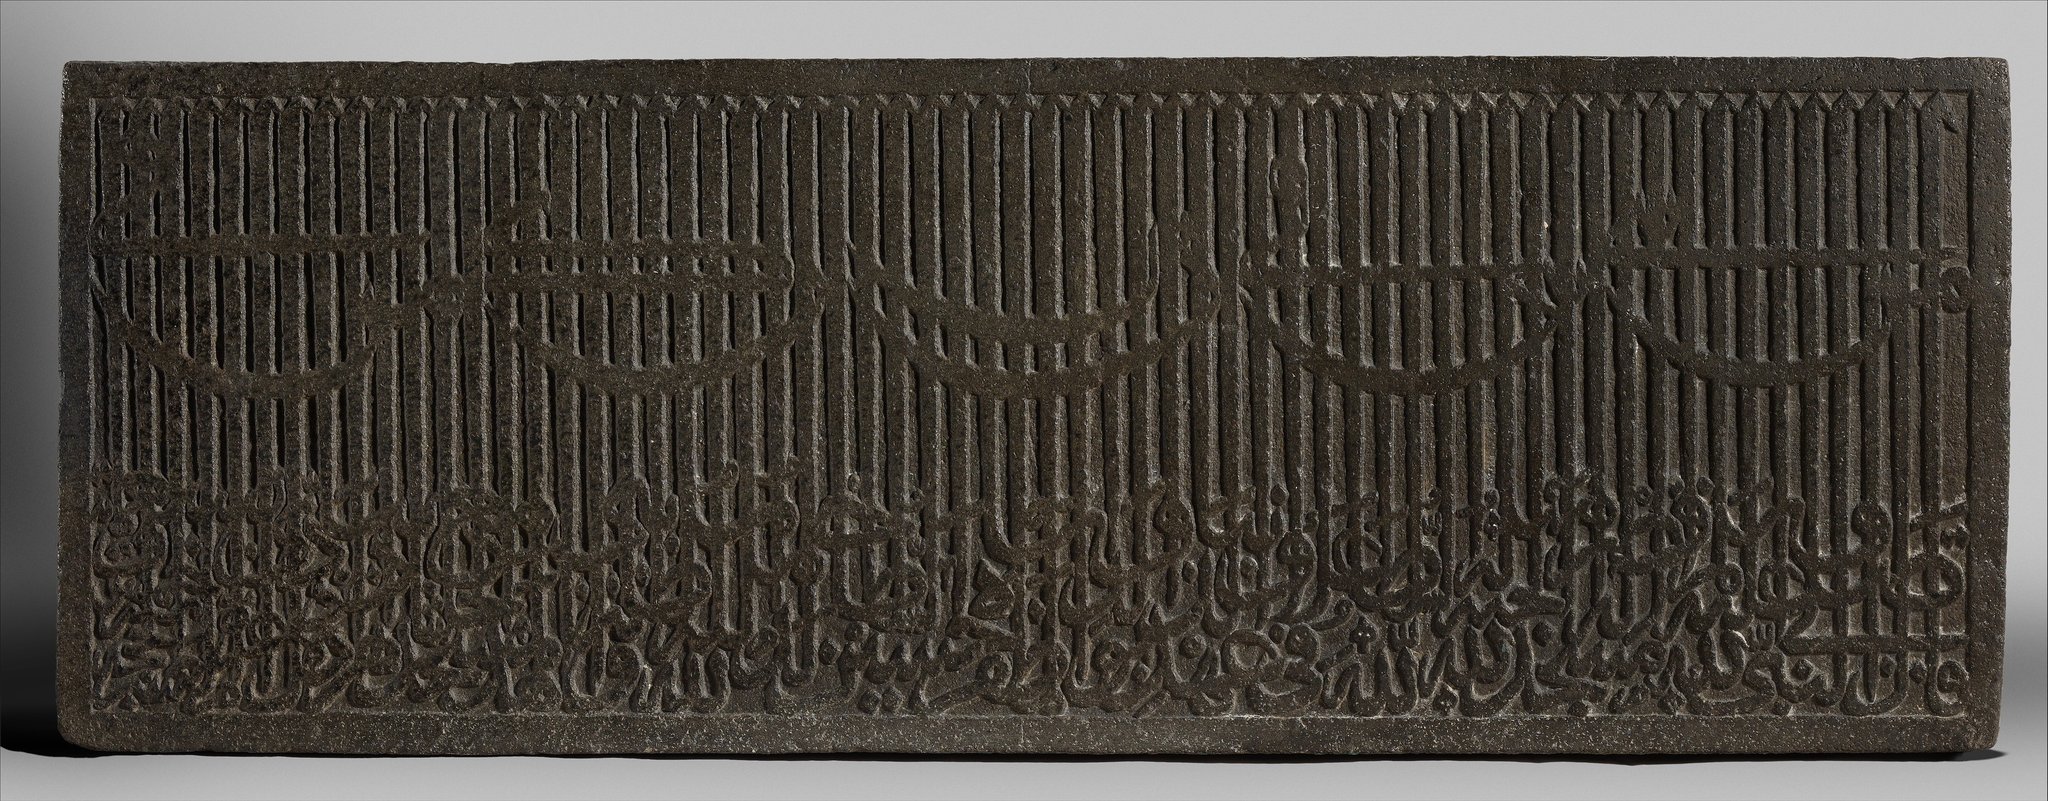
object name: panel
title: Dedicatory Inscription from a Mosque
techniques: carving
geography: india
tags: arabic